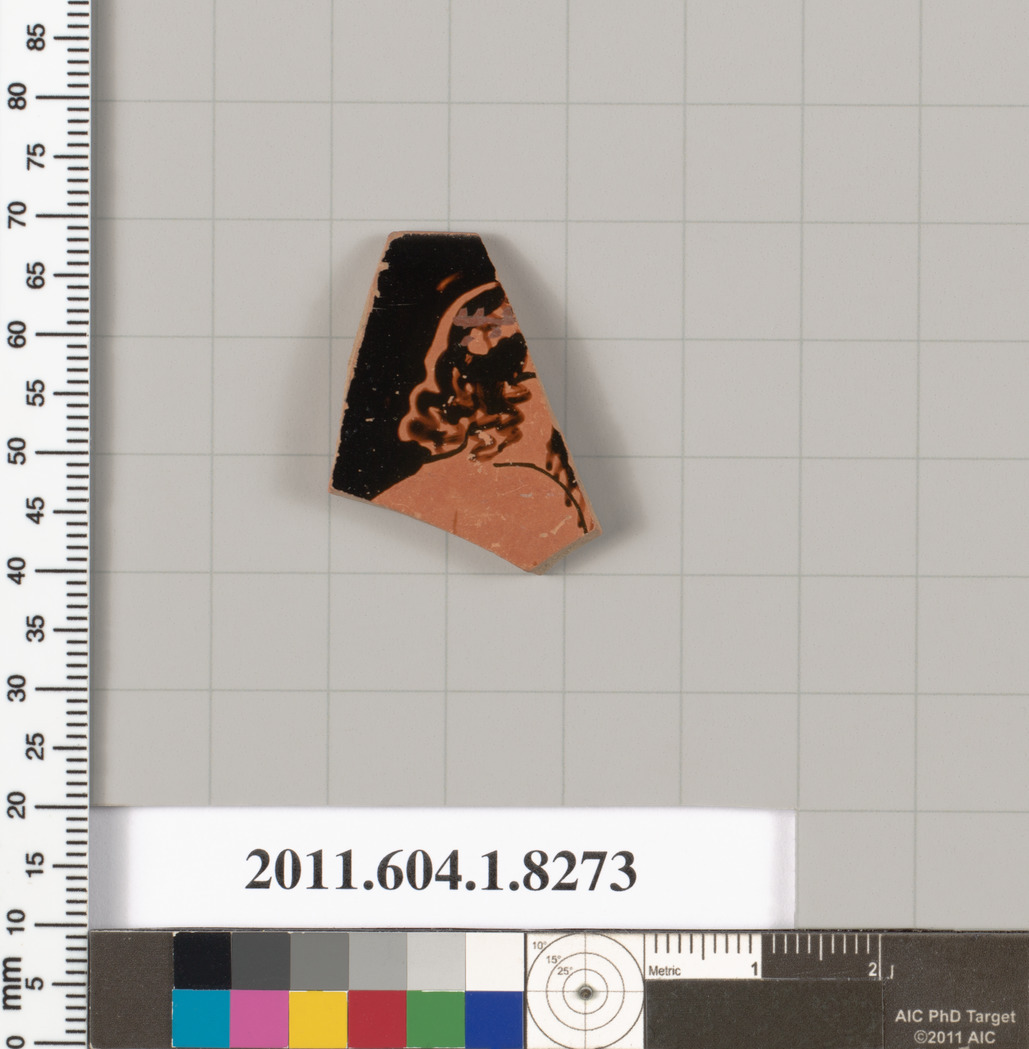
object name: kylix fragment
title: Terracotta rim fragment of a kylix (drinking cup)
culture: greek, attic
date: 400-376 BCE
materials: terracotta